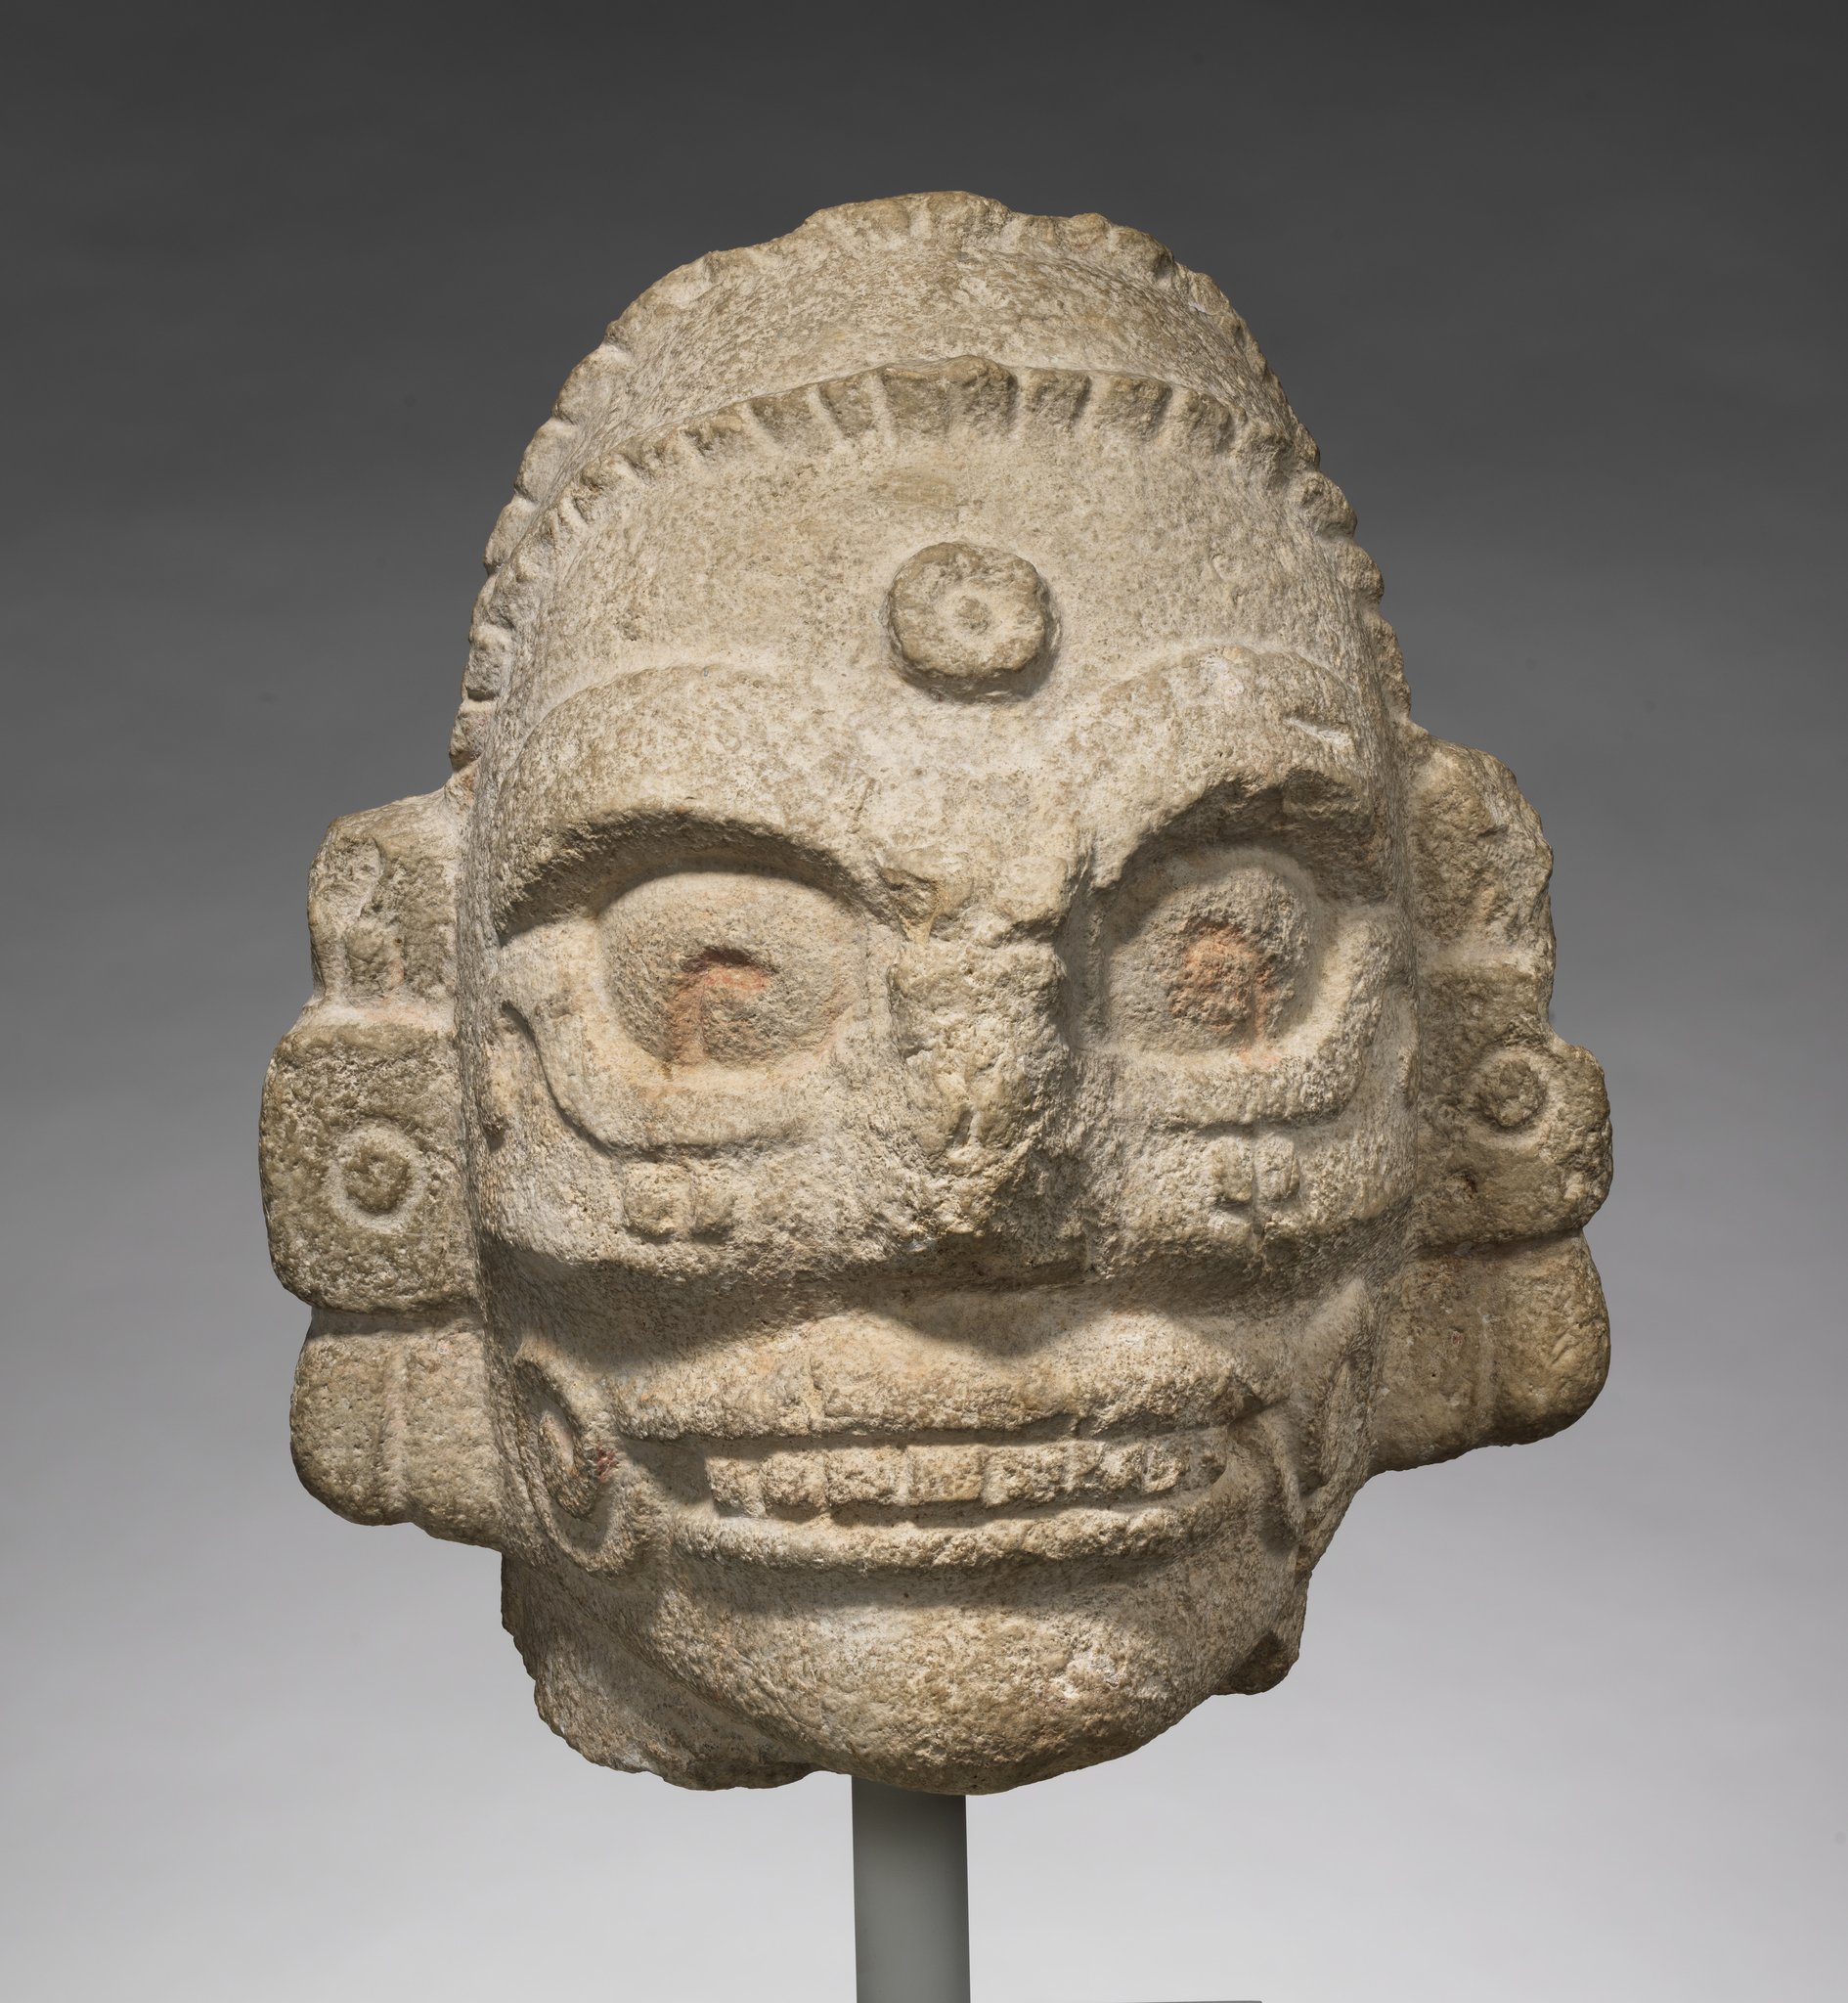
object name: head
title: Head of a Rain God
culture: maya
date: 901-1100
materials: limestone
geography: mexico